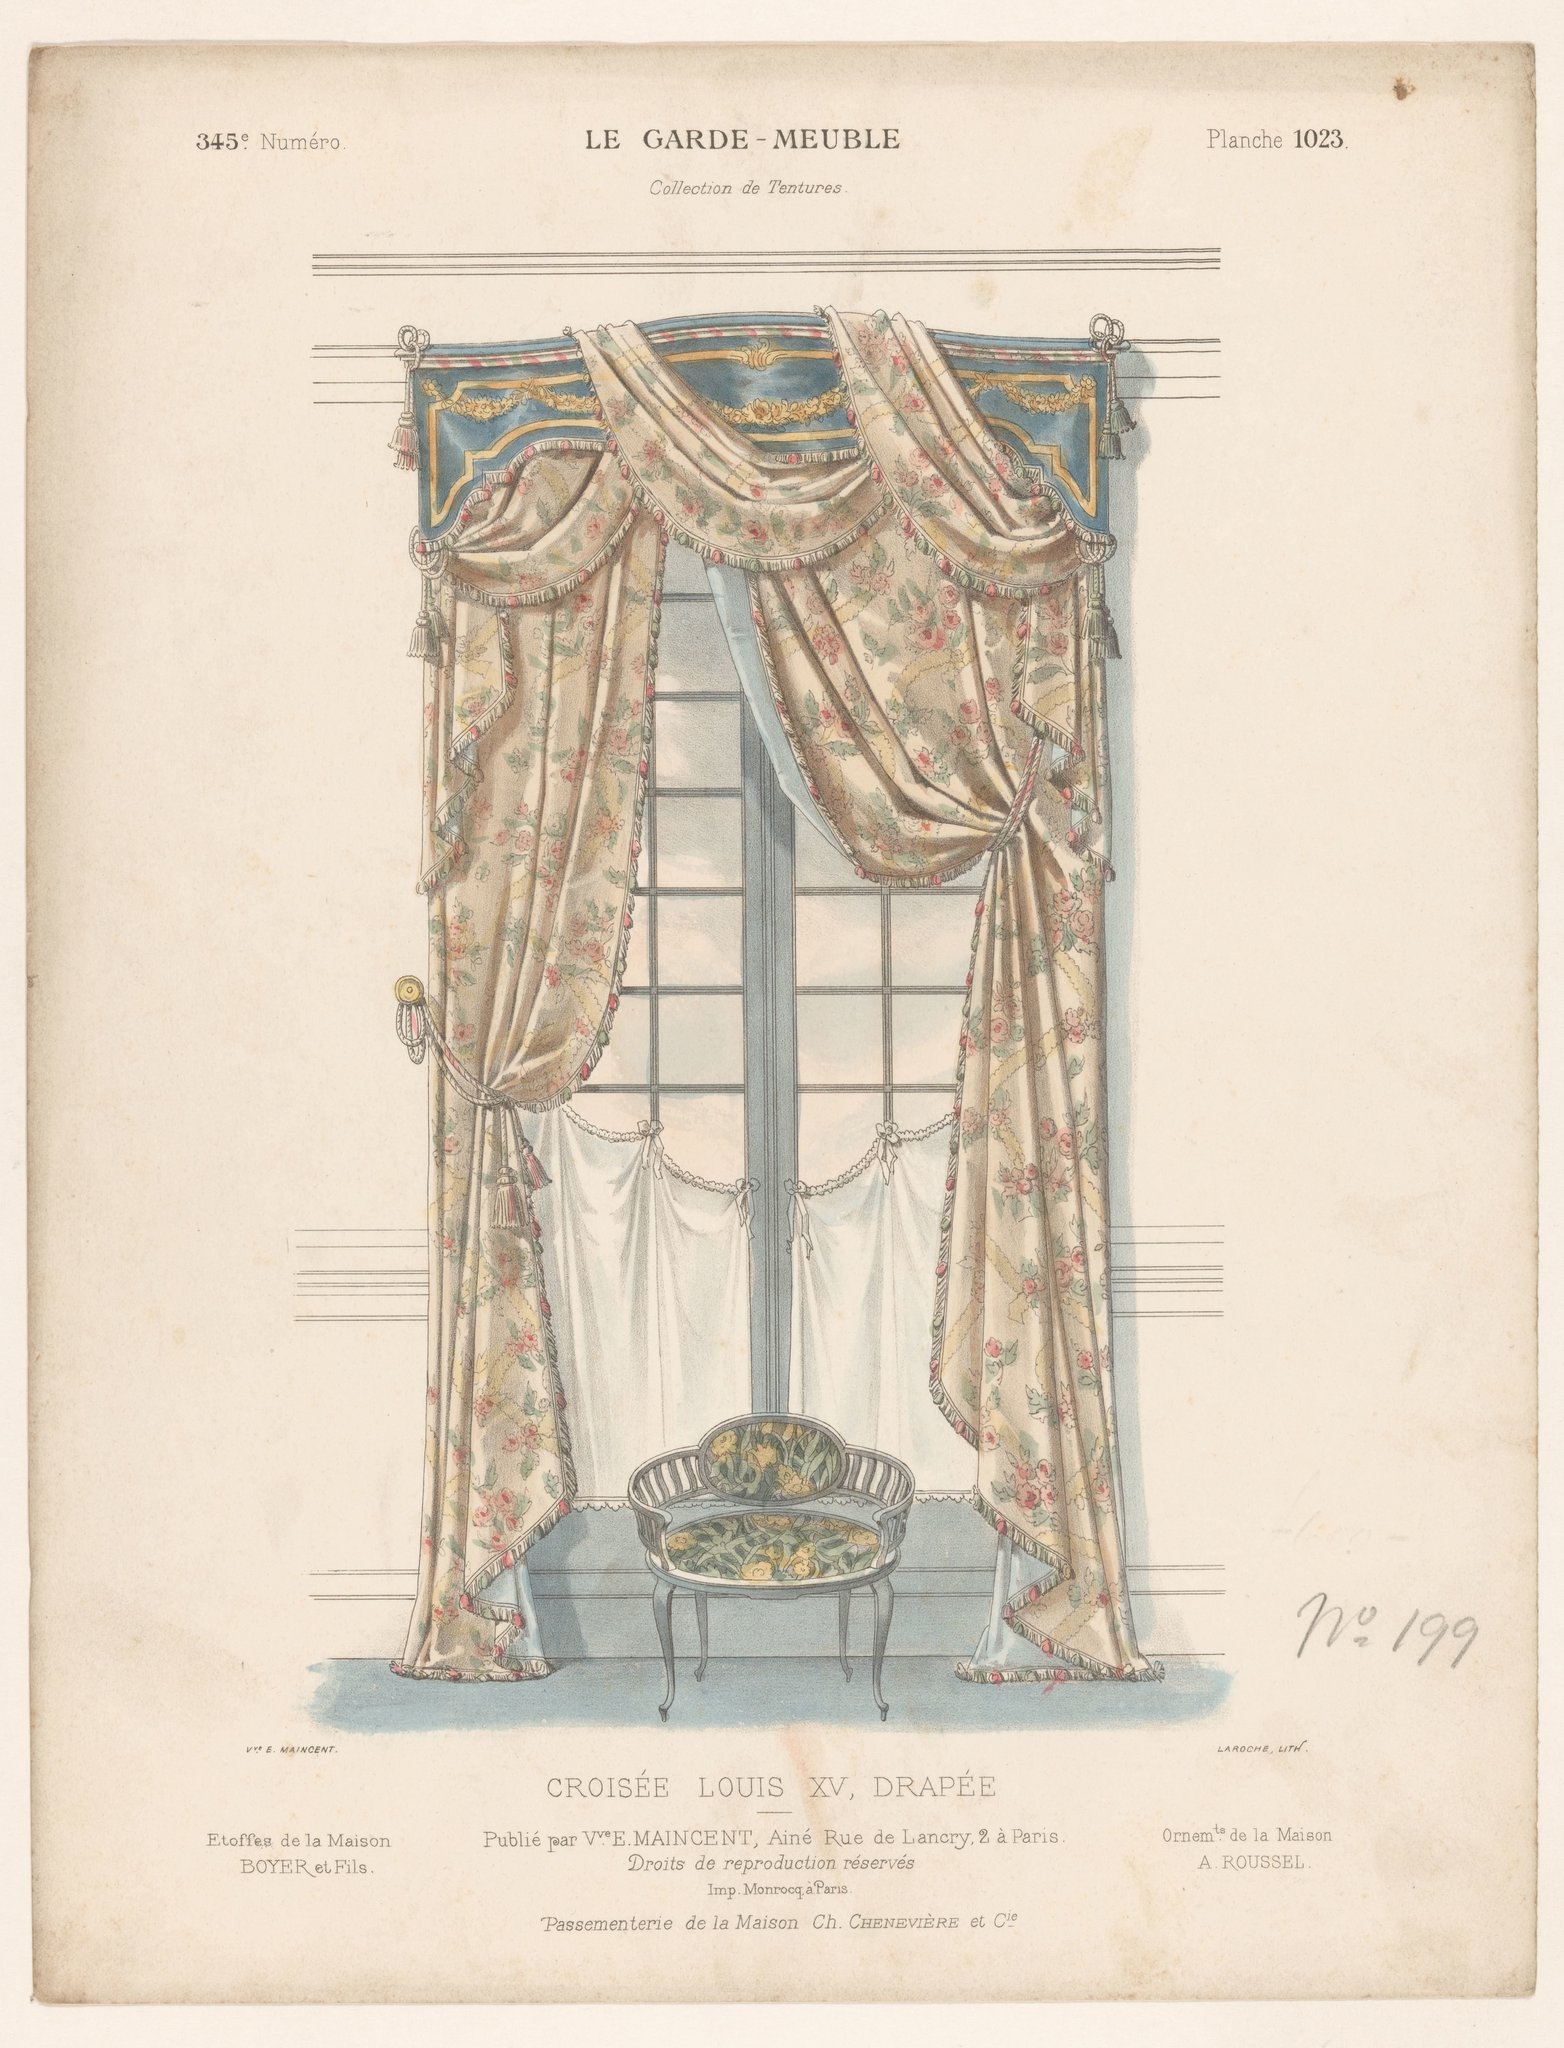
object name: print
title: Venster met gordijnen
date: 1895-1910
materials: paper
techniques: hand coloring, lithograph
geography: paris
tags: window, hangings and drapery, chair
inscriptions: : ‘Droits de reproduction réservés.’, annotation: ‘no. 199’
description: Kruisvenster met stoel en gedrapeerde gordijnen in de Lodewijk XV-stijl. Prent uit 344e Livraison.